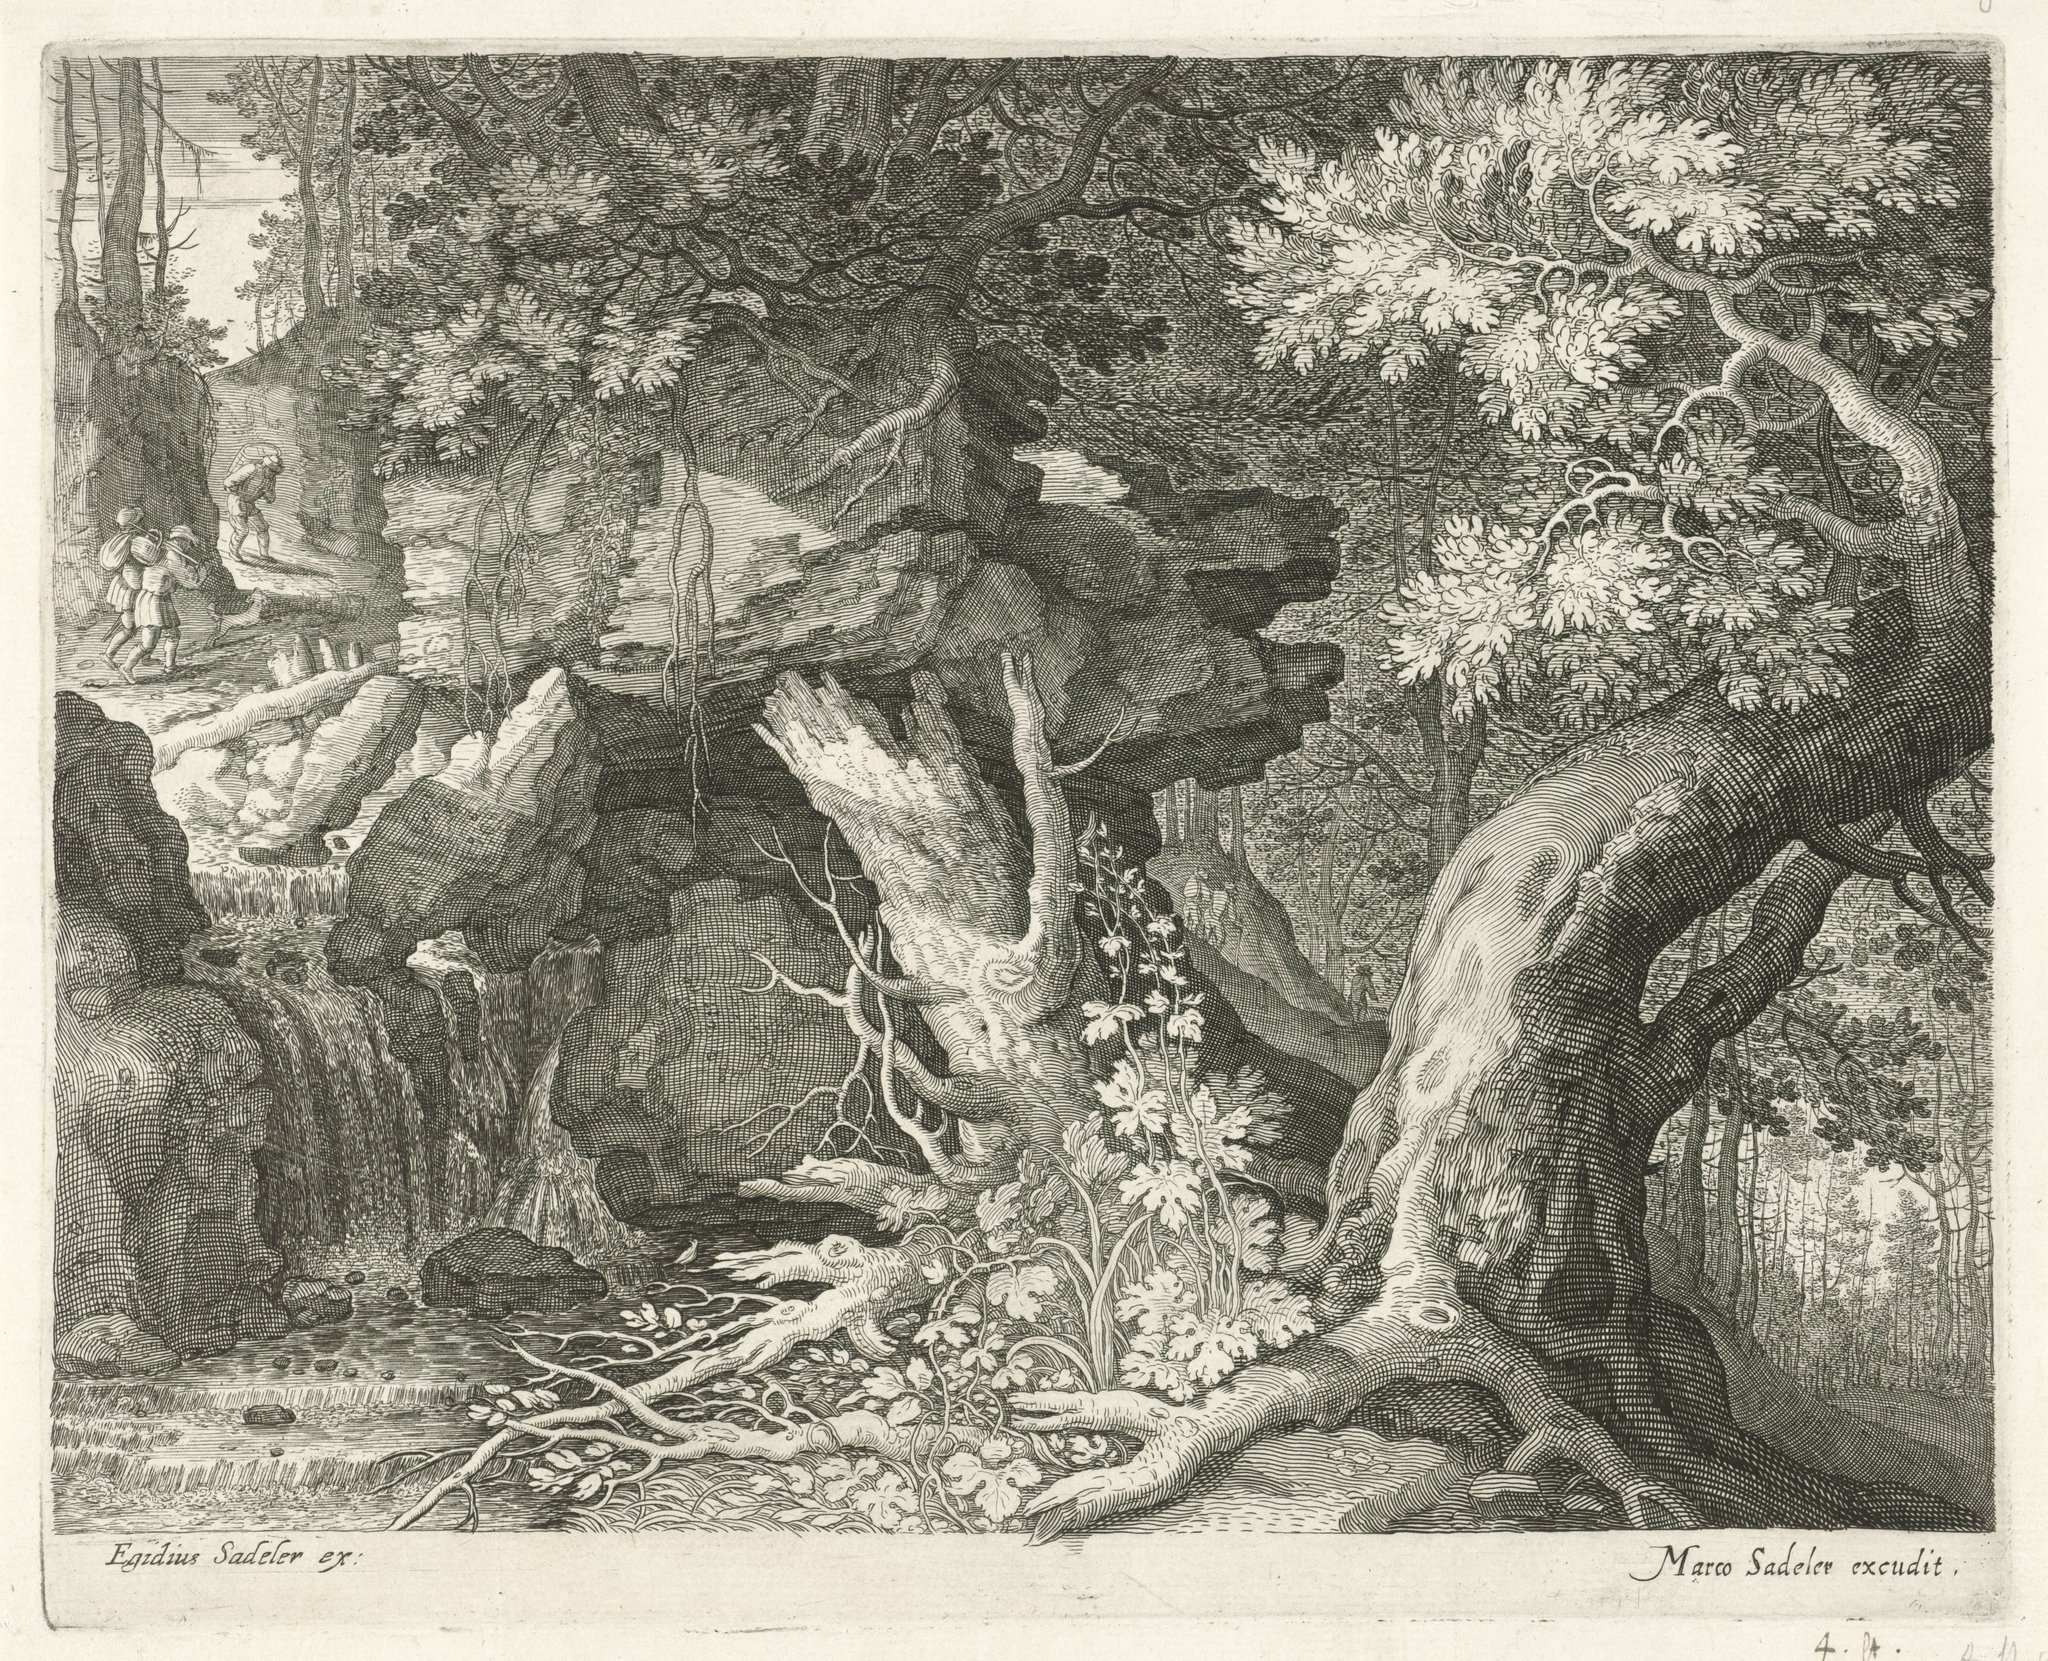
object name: print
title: Zes landschappen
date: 1597-1629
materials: paper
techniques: engraving, etching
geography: prague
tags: waterfall, 'en route', traveller under way, forest, wood (+ landscape with figures, staffage)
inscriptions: inscription: ‘4Ft.’, collector's mark: Lugt 2228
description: Boslandschap met dikke boom en een rots op de voorgrond. Onder de rots een kleine waterval. Linksboven drie mannen en een hond op een bospad. De vierde prent in een zesdelige reeks met landschappen.